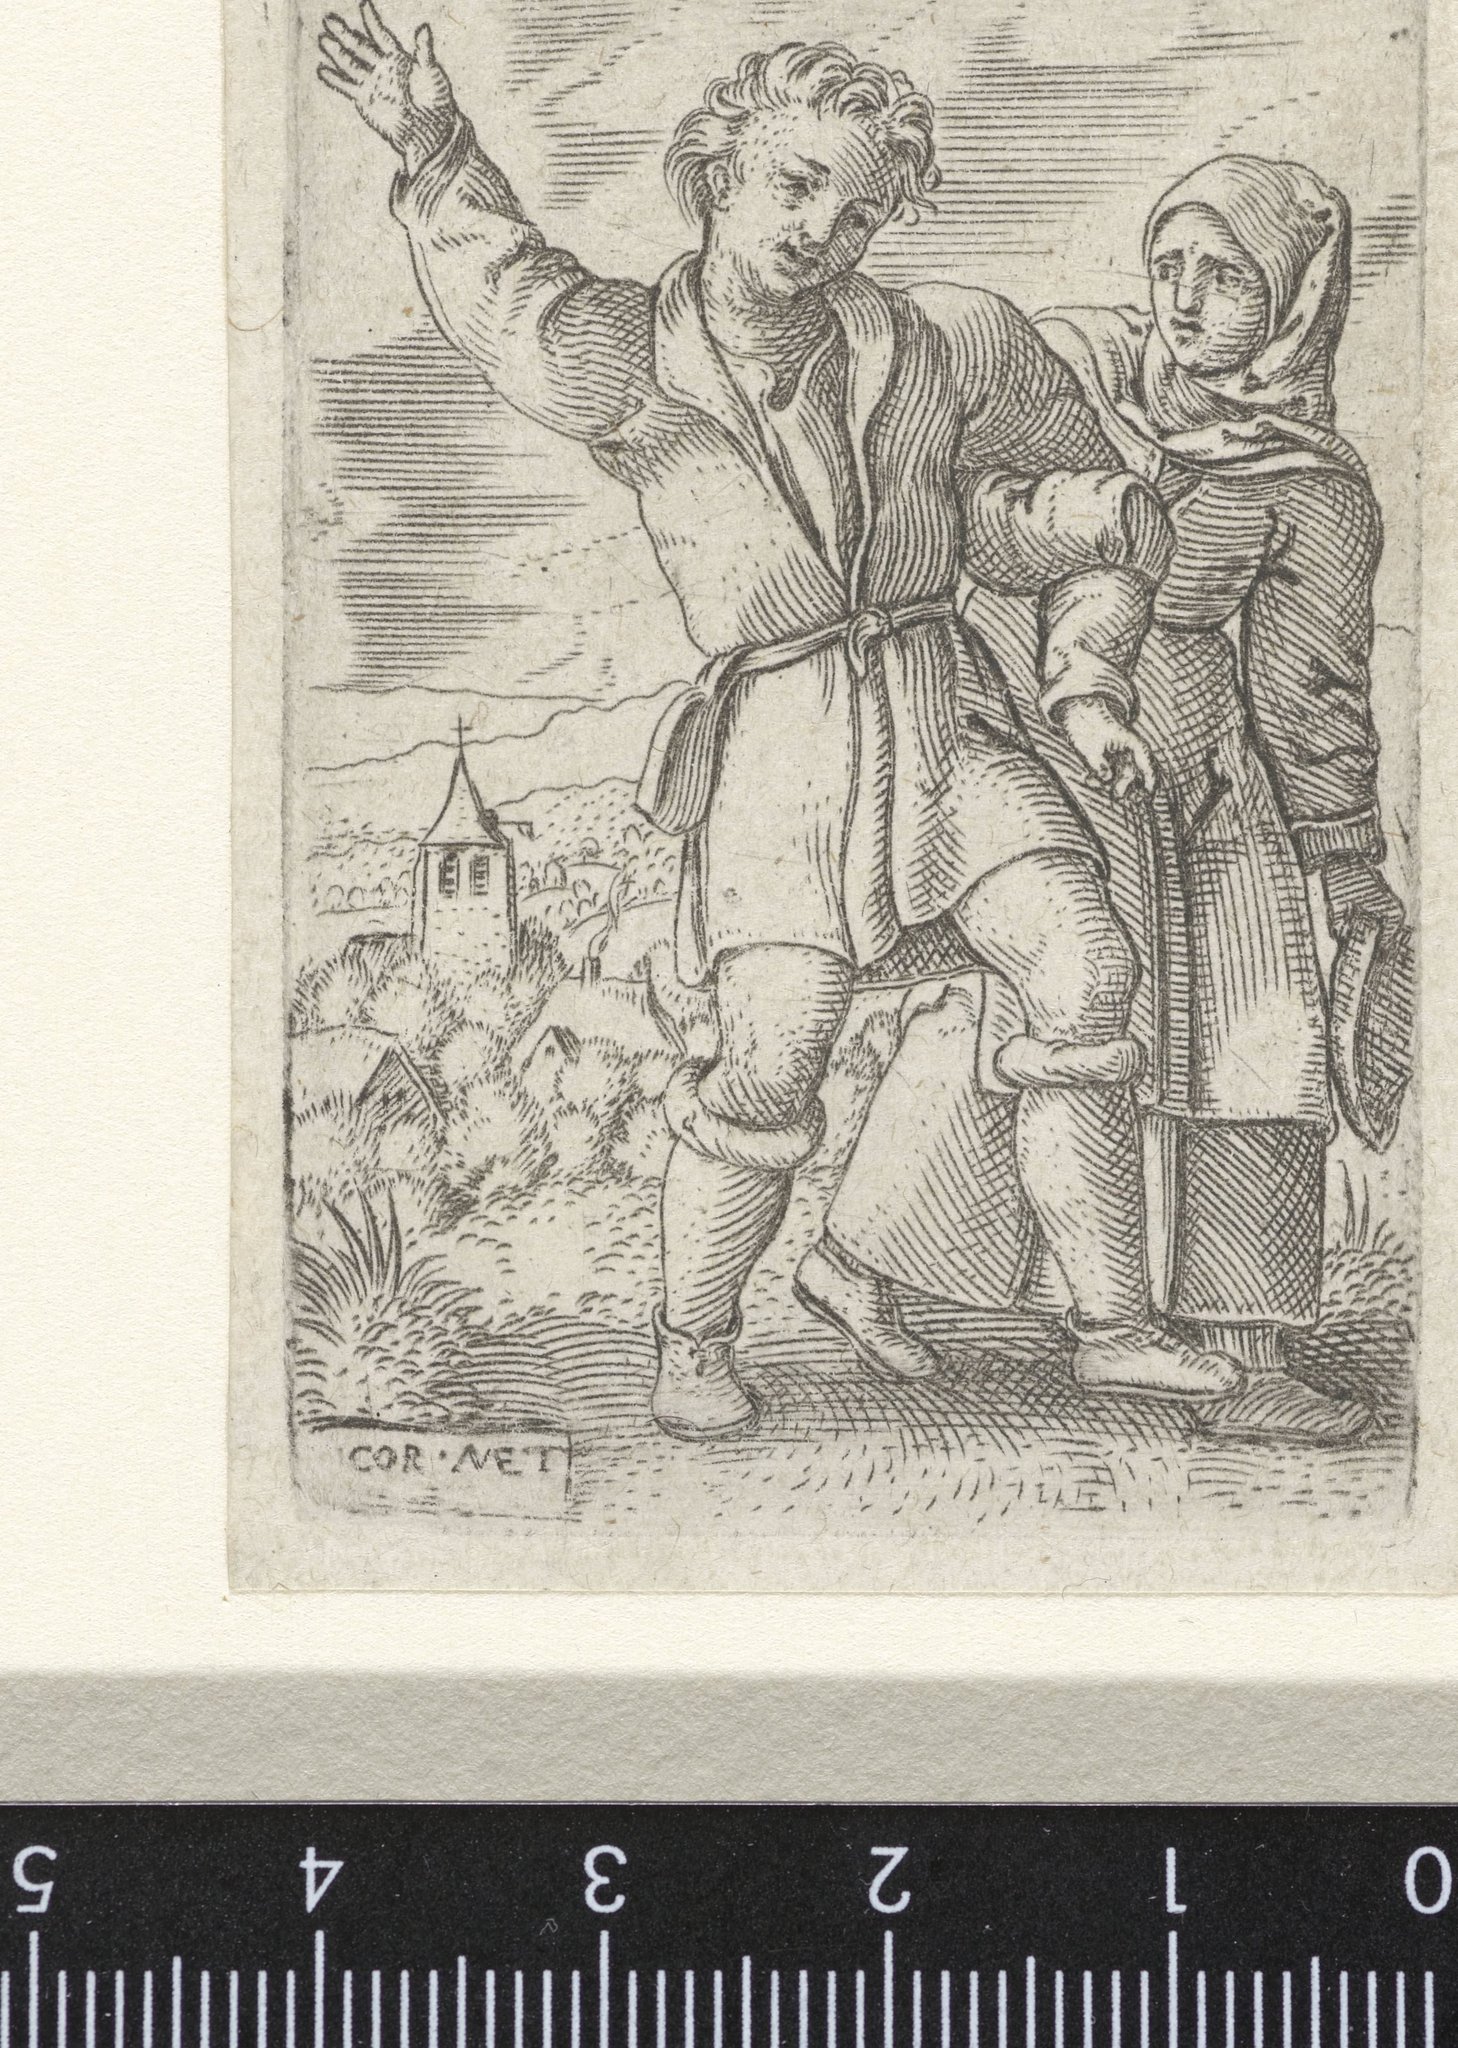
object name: print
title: Dronkeman geleid door een vrouw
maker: cornelis massijs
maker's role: painter, print maker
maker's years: 1510-1557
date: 1538-1557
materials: paper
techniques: engraving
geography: antwerp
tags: drunkard, walking arm in arm, parts of church exterior and annexes: tower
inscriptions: collector's mark: Lugt 2233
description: In een landschap met een kerktoren op de achtergrond leidt een vrouw een dronkeman aan de arm.